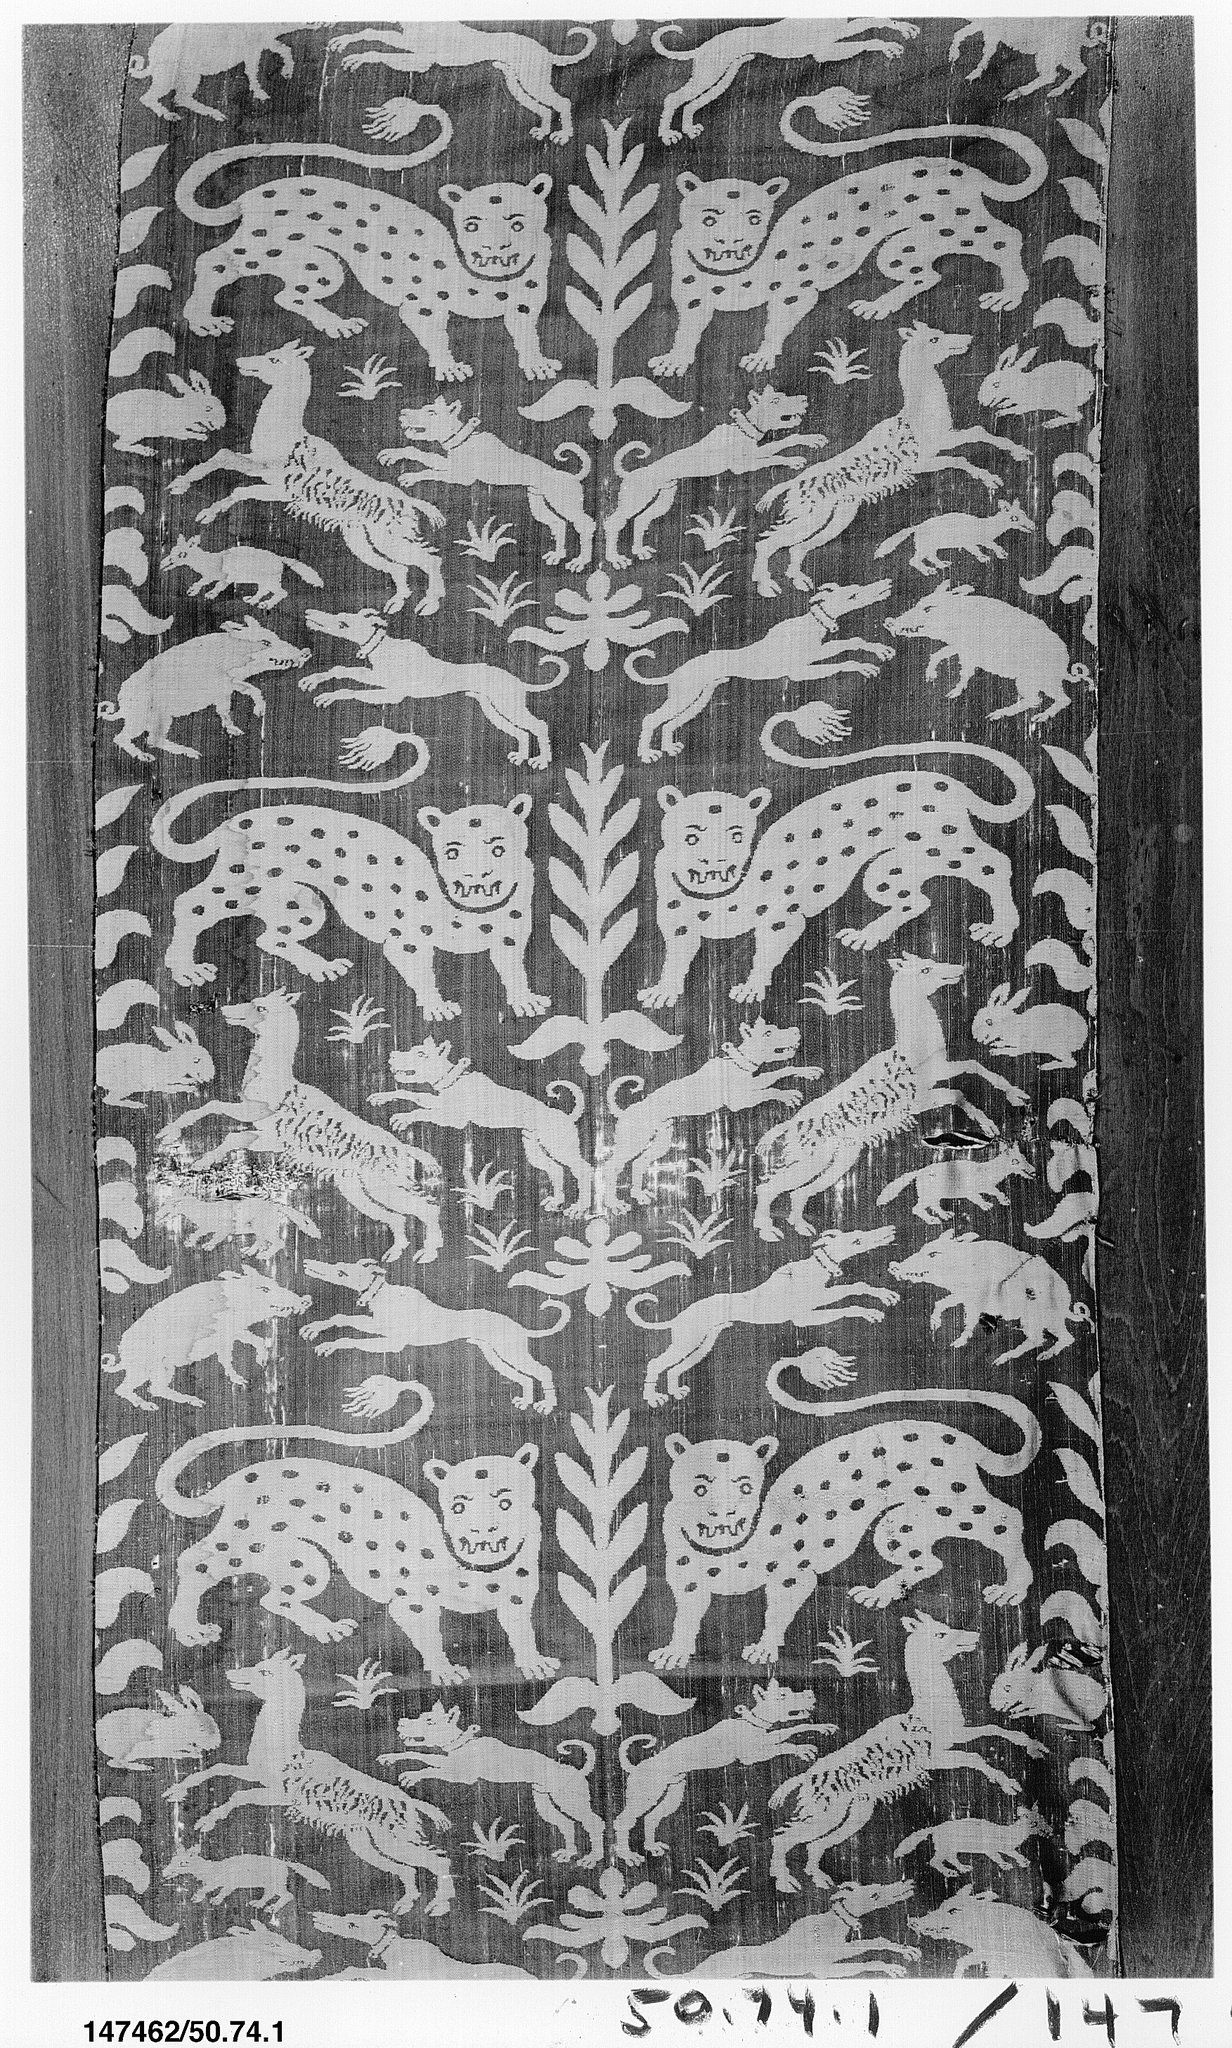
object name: piece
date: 1501-1600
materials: silk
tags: dogs,leopards,leaves